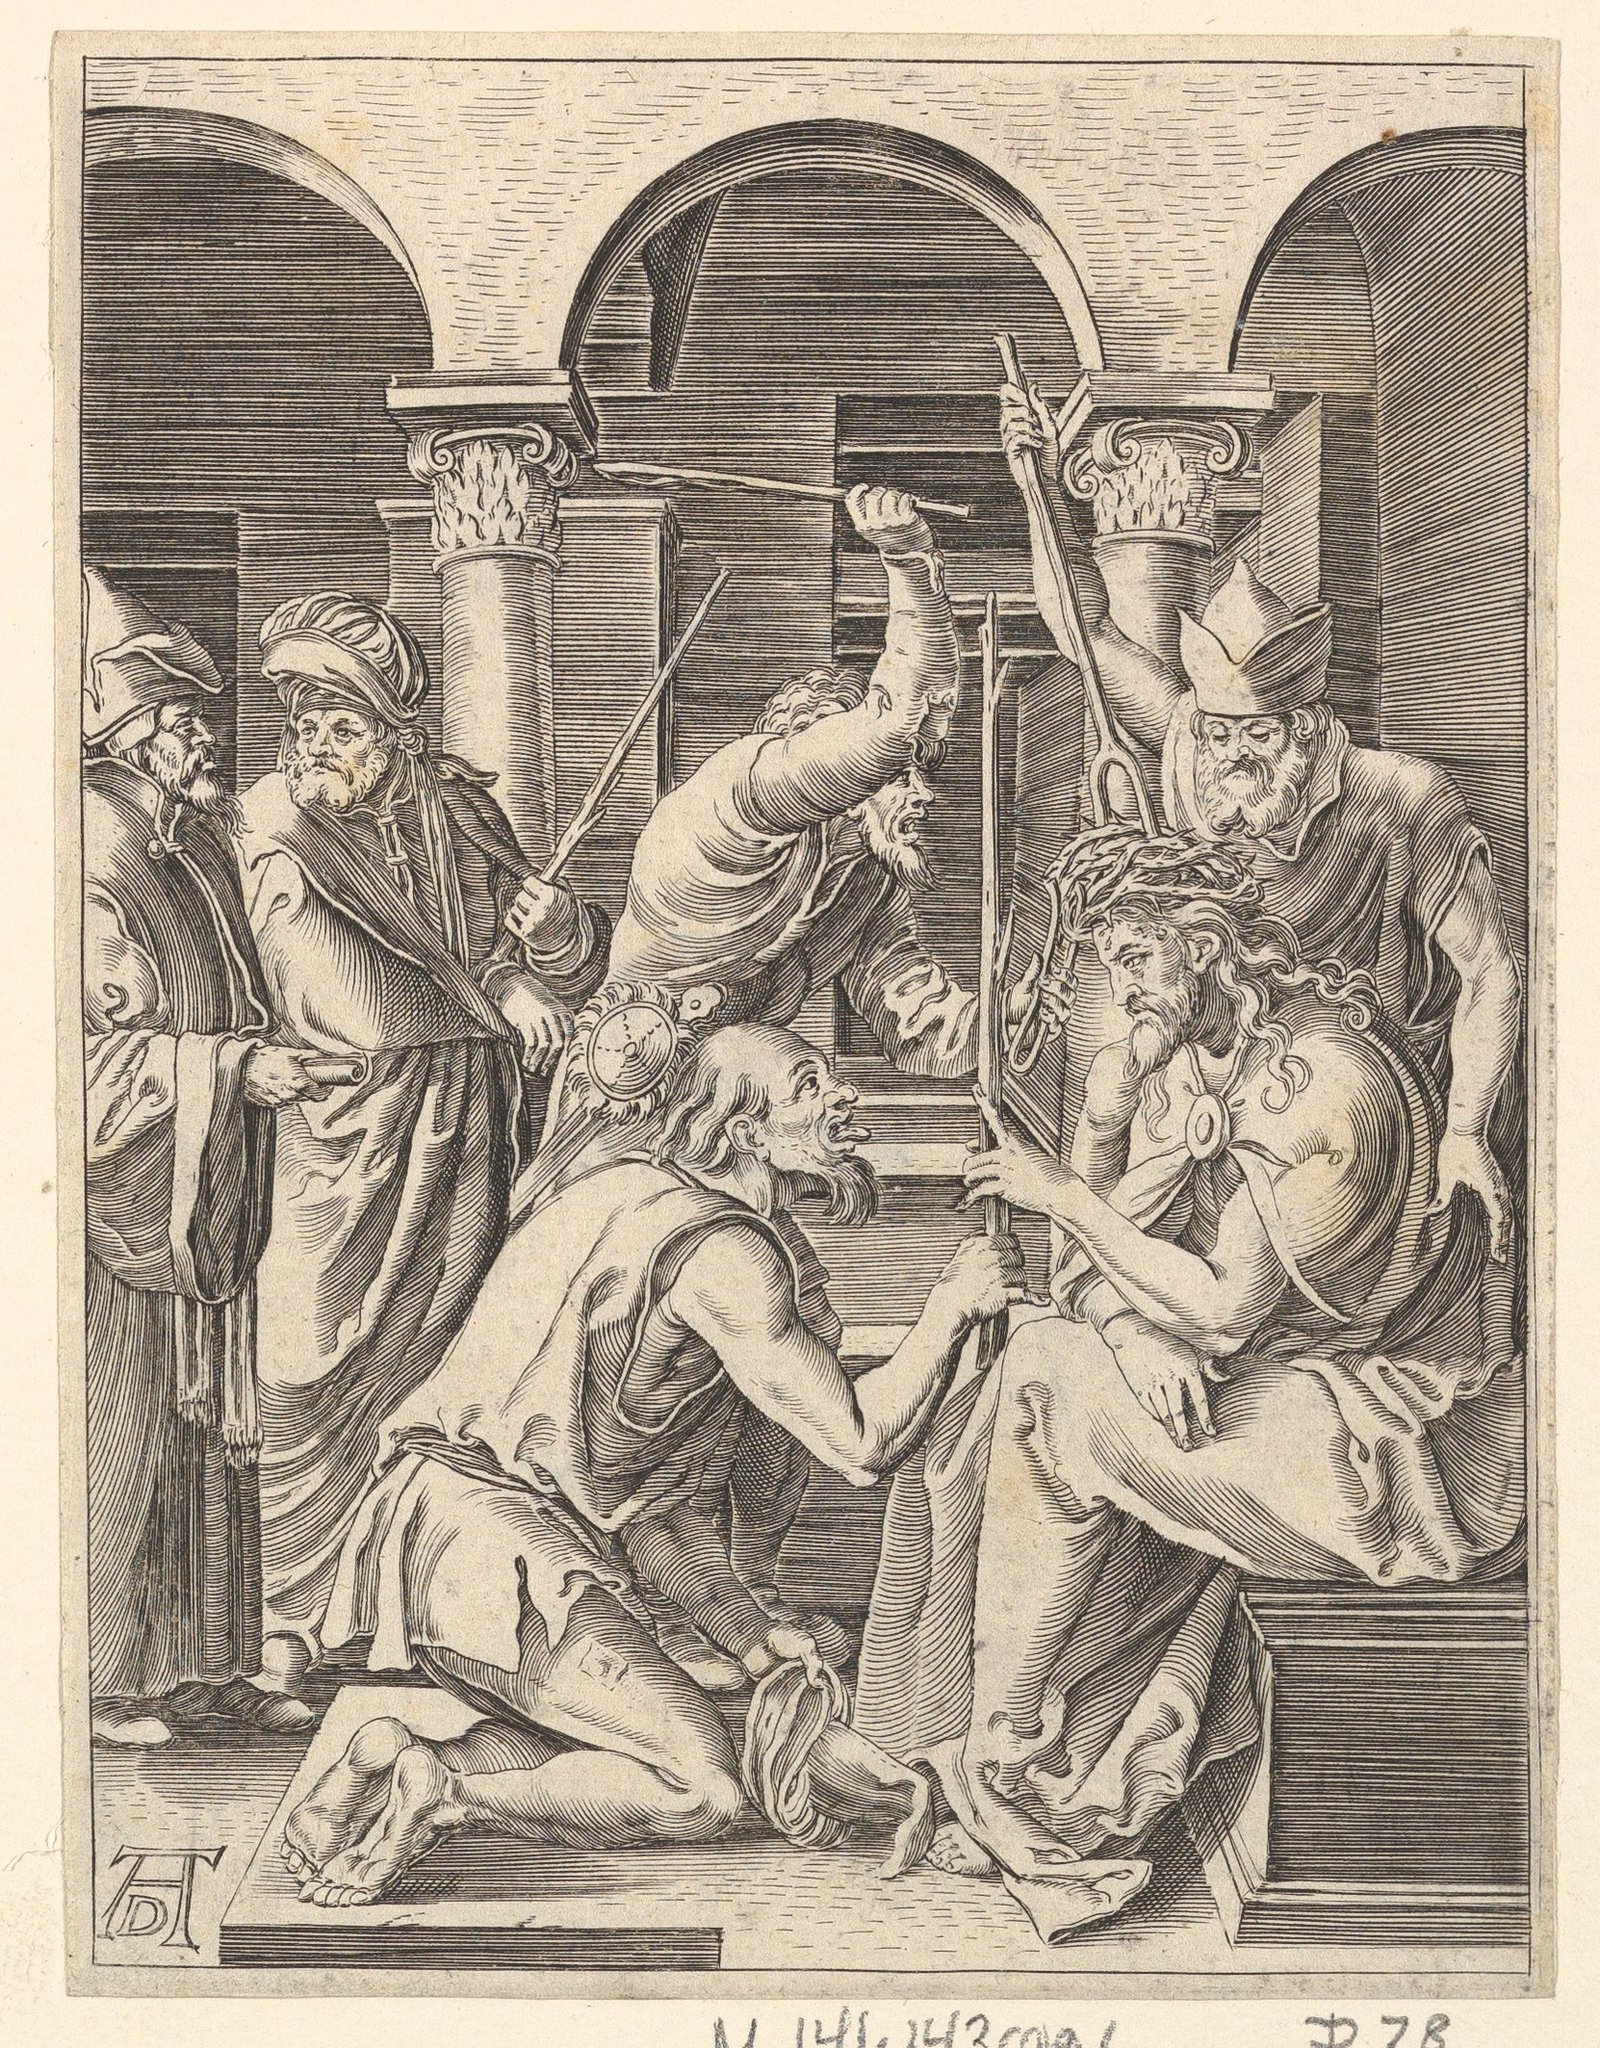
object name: print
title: Engraved copies of The Little Passion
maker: albrecht dürer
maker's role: artist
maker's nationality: german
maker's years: 1471-1528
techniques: engraving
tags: men,christ